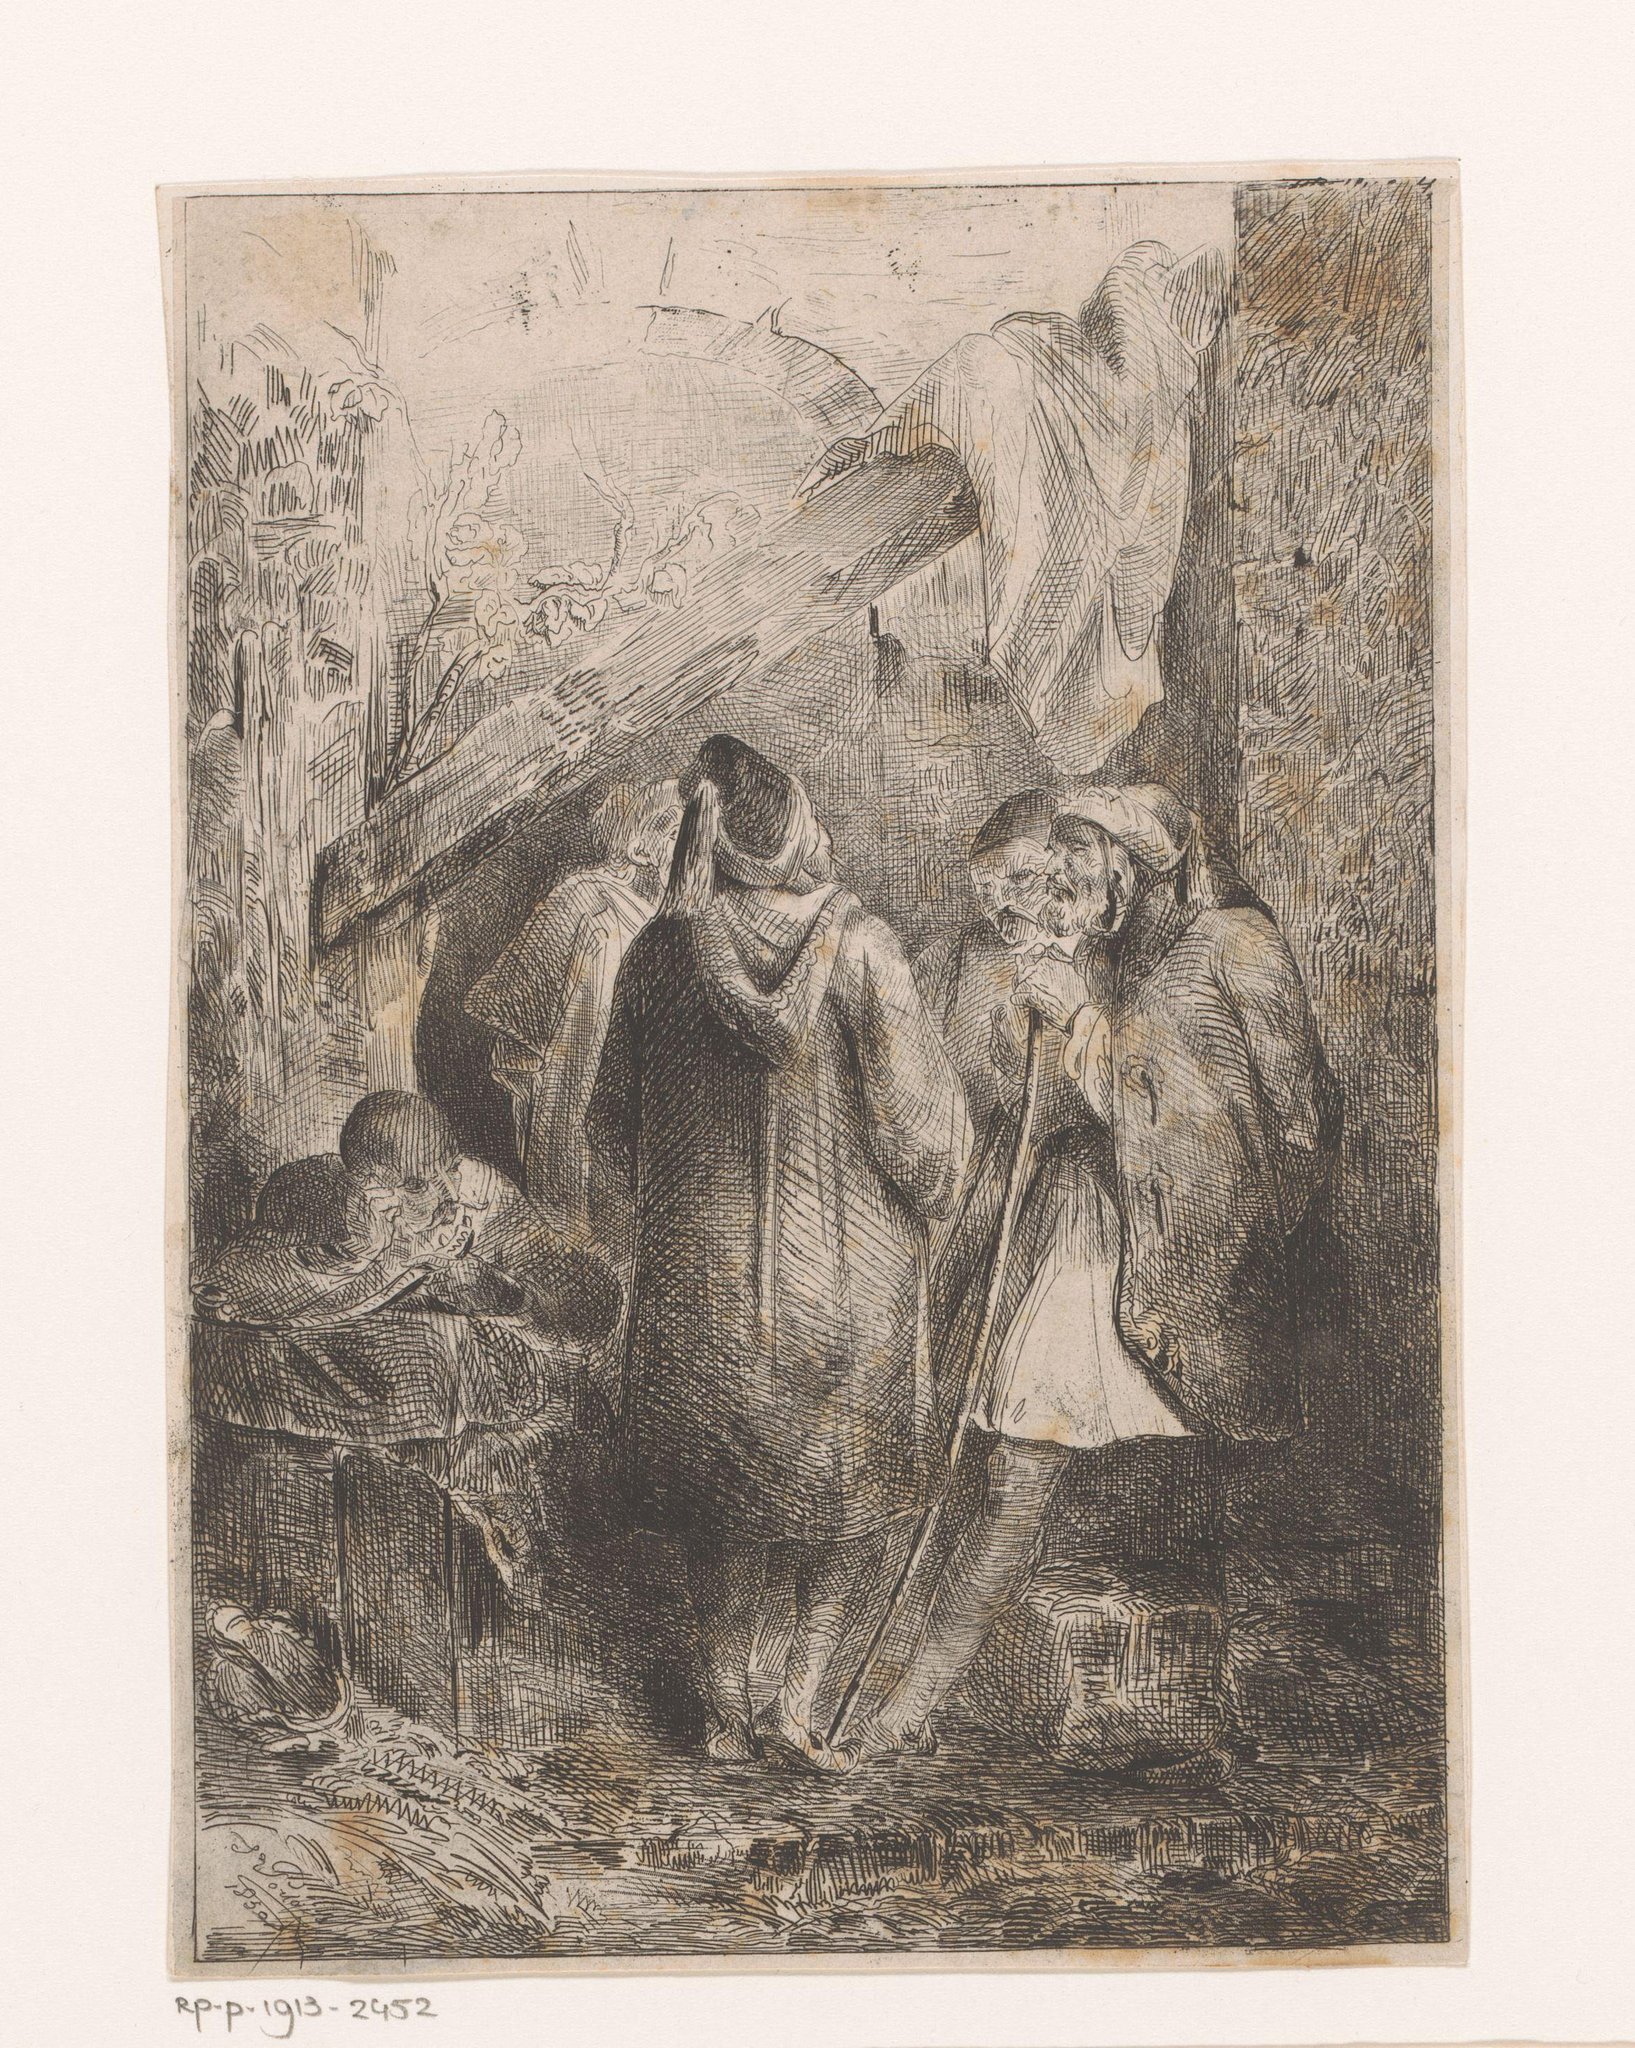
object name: print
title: Vijf mannen uit het Midden-Oosten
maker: jean françois portaels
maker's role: print maker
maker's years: 1818-1895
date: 1850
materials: paper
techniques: drypoint, etching, roulette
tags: adult man, conversation, dialogue; conversation piece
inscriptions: collector's mark: Lugt 2228, collector's mark: Lugt 1485